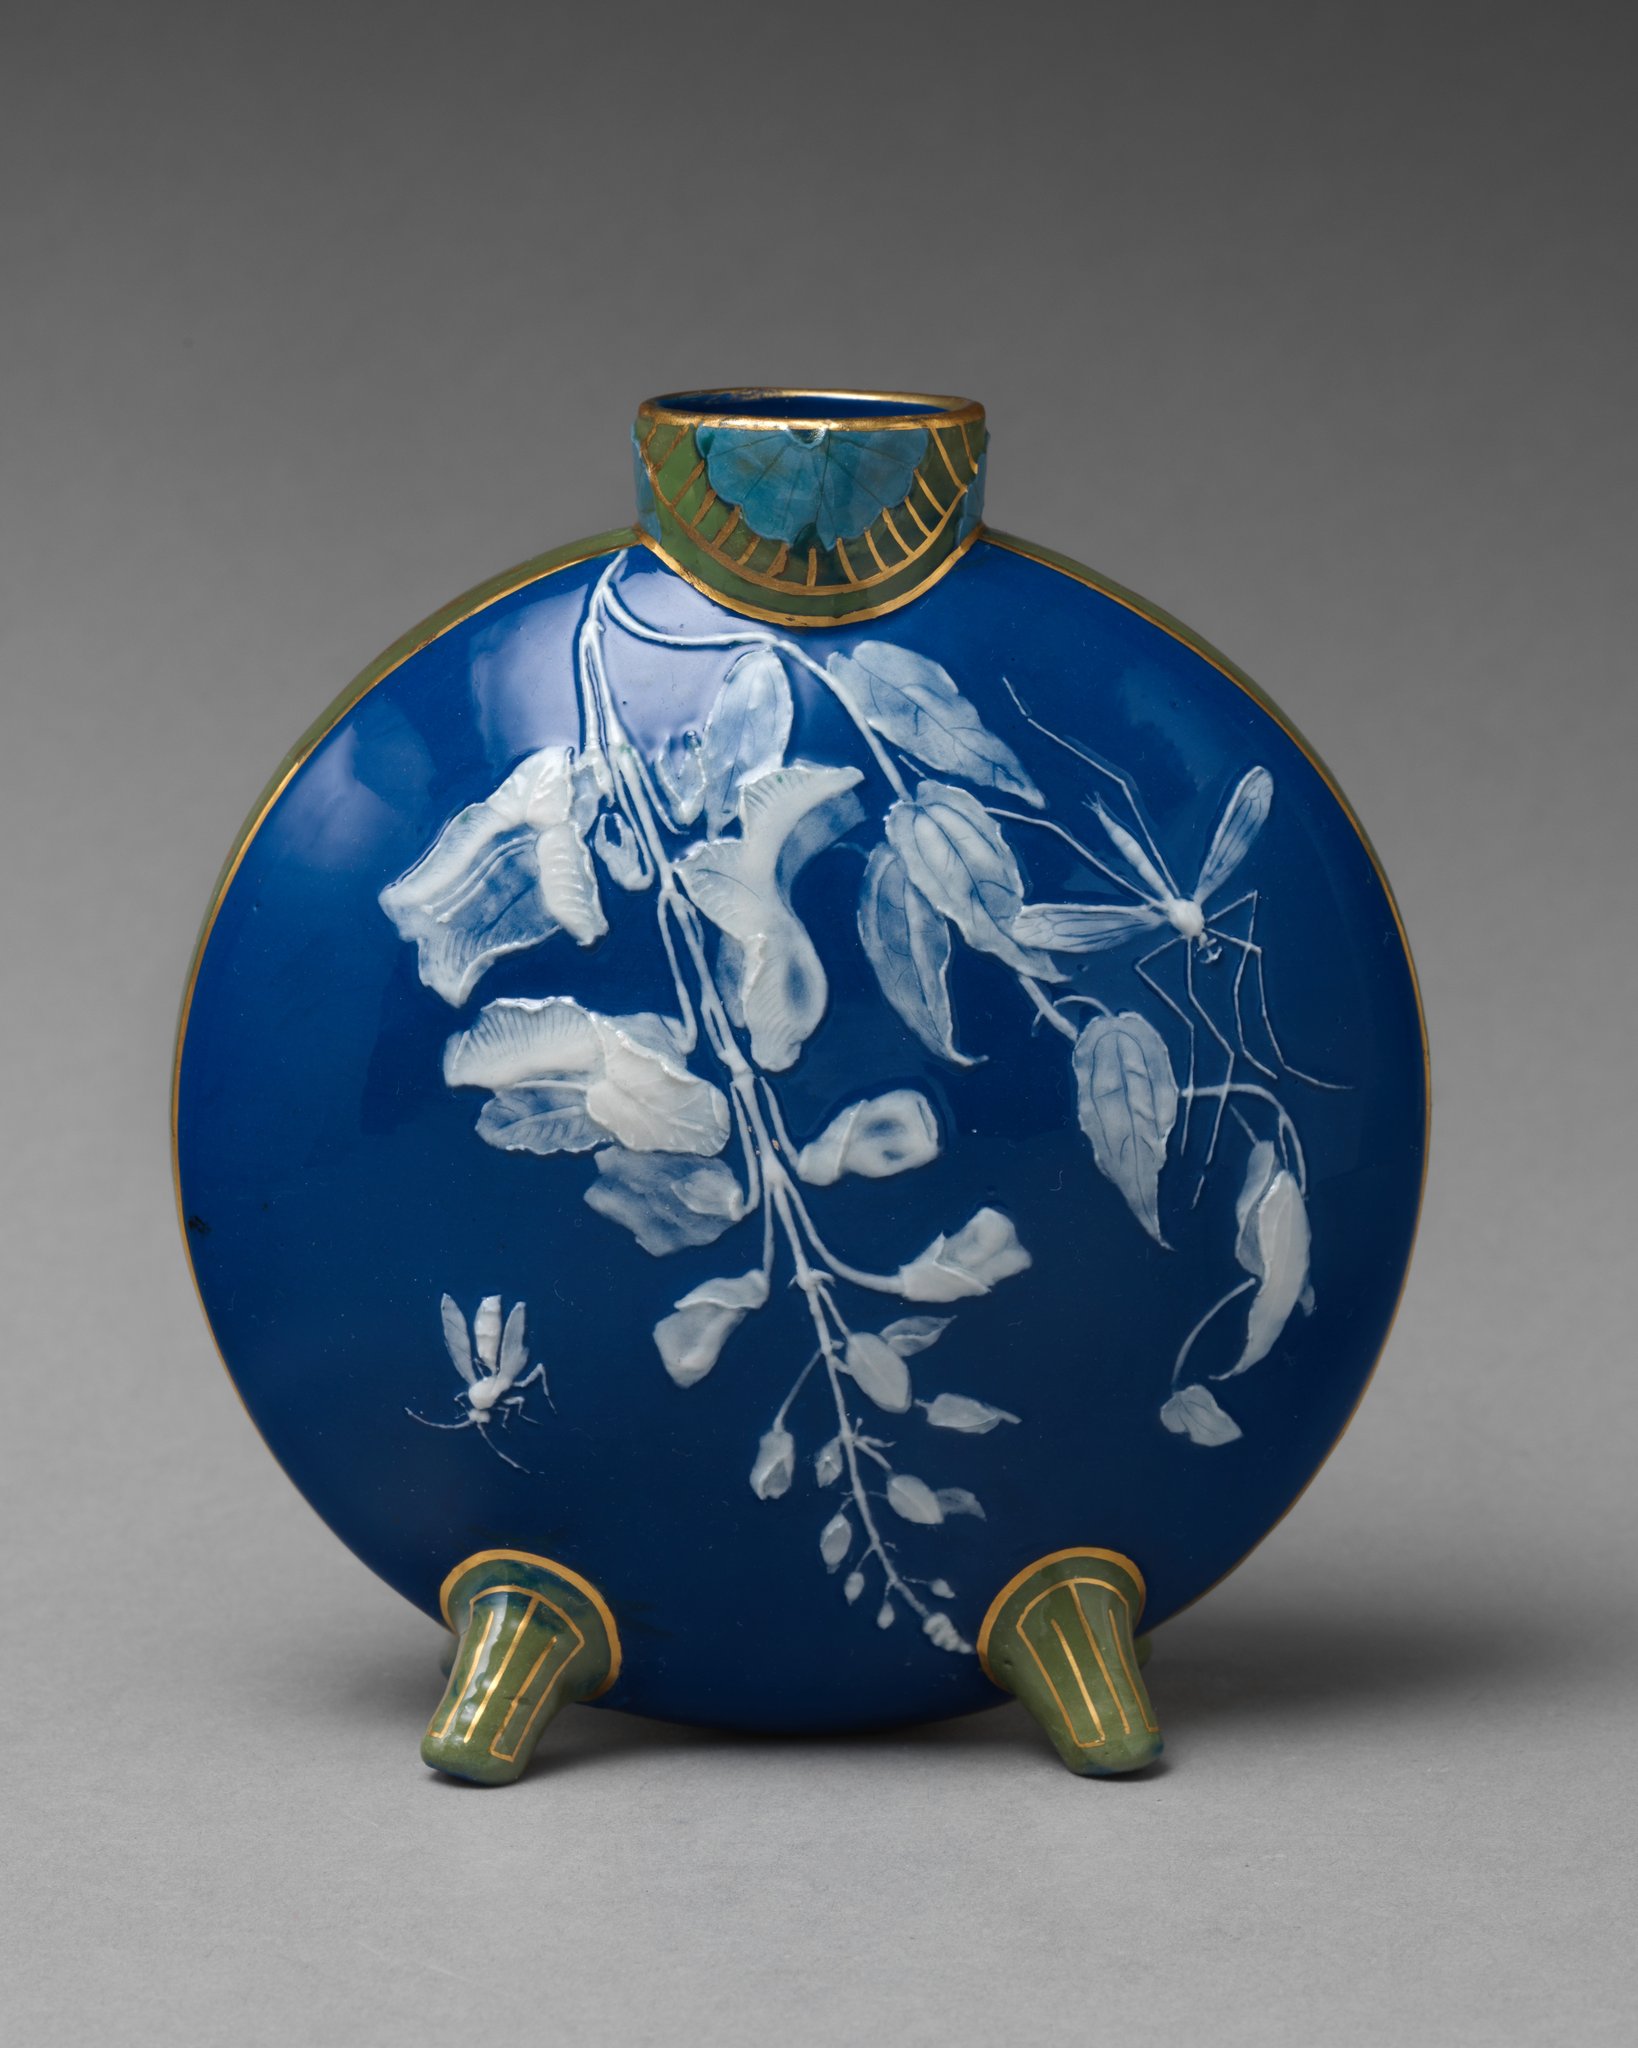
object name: moon flask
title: Moon flask with mosquito motif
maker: minton(s)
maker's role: maker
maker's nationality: british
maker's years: 1793-2001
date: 1870-1879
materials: porcelain